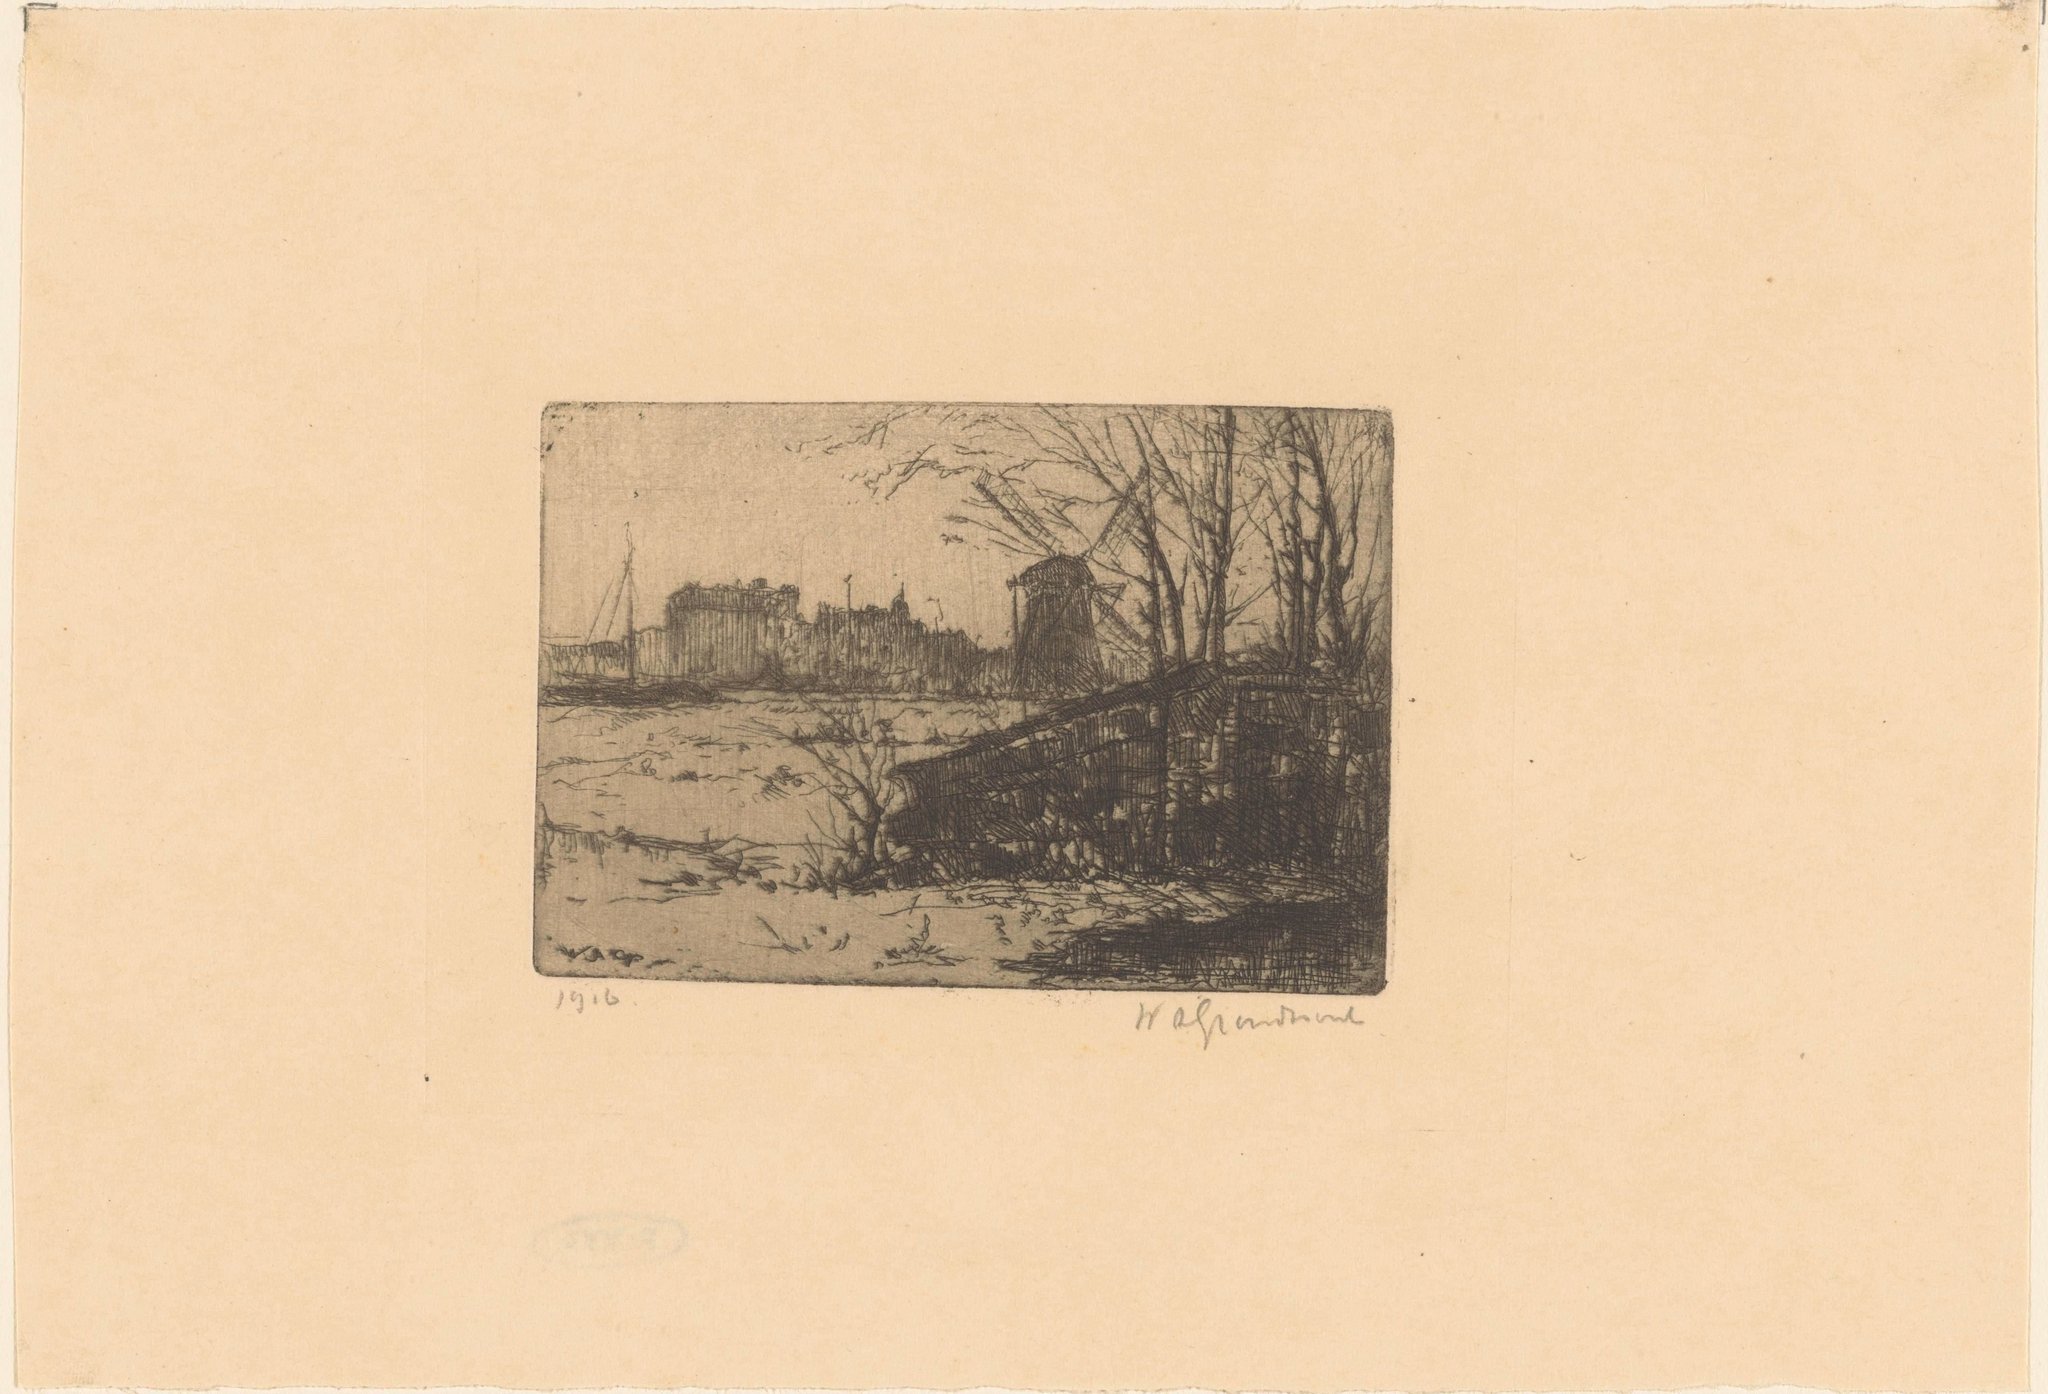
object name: print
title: Landschap met molen in de Binckhorst in Den Haag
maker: willem adrianus grondhout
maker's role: draughtsman, painter, print maker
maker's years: 1878-1934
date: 1916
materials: paper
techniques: etching, intaglio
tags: trees (+ bare plant), windmill in landscape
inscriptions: collector's mark: Lugt 2228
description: Op de voorgrond kale bomen. Op de achtergrond het silhouet van een molen en andere gebouwen.